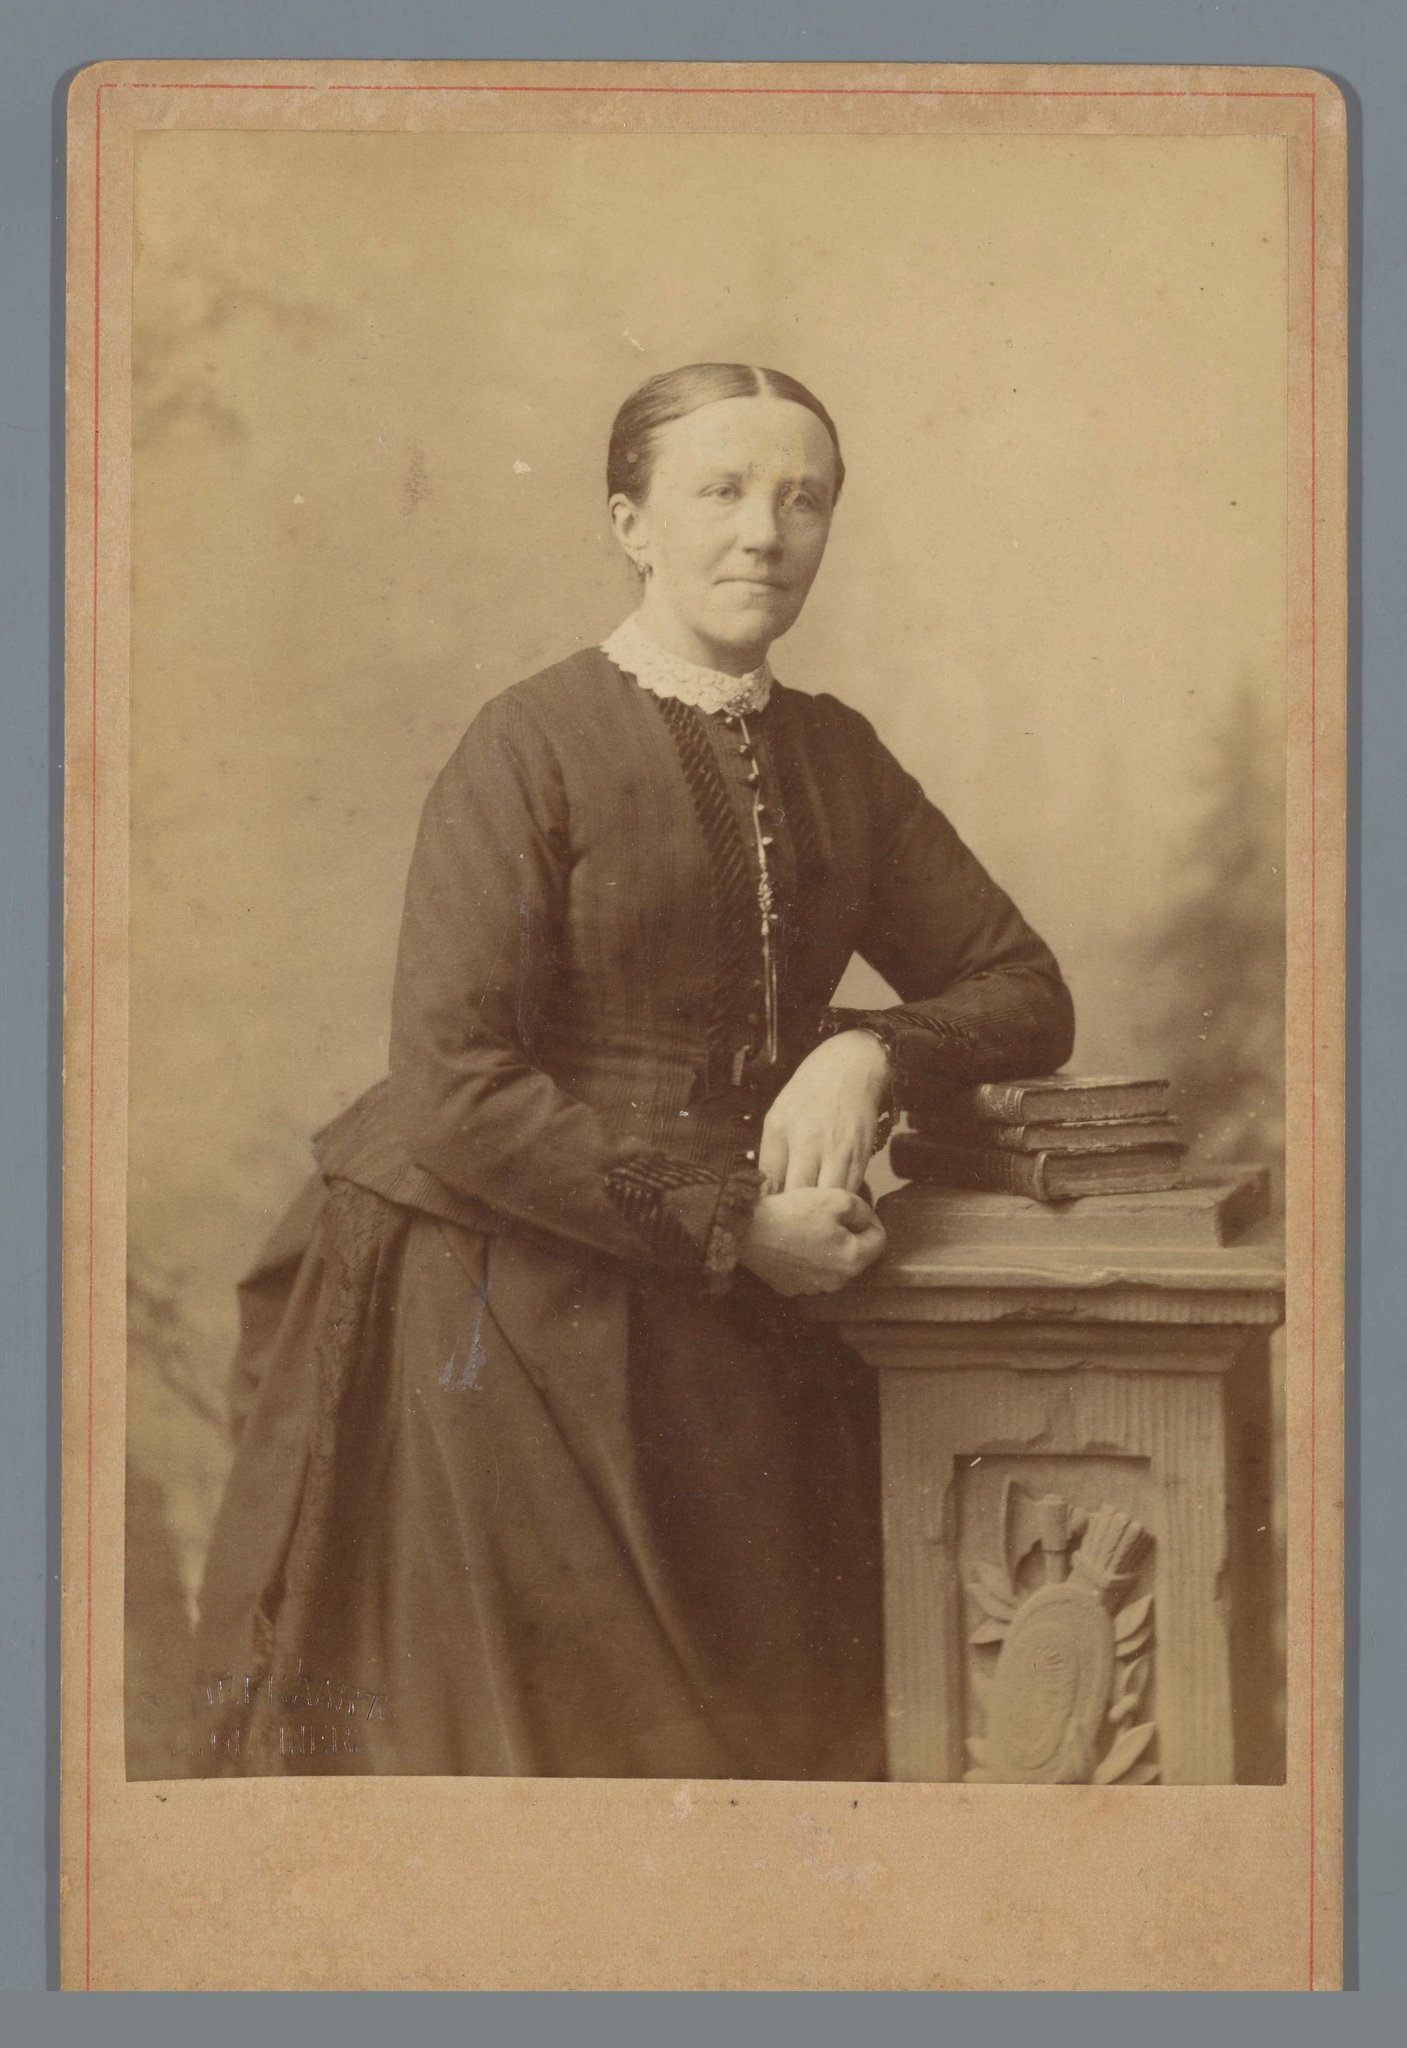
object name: cabinet photograph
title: Portret van een onbekende vrouw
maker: albert greiner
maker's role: fotograaf, fotostudio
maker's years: 1833-1890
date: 1861-1890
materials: cardboard, photographic support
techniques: albumen print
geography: amsterdam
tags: adult woman, studio requisites ~ photographer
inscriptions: name: ‘Proefkaart A. Greiner.’